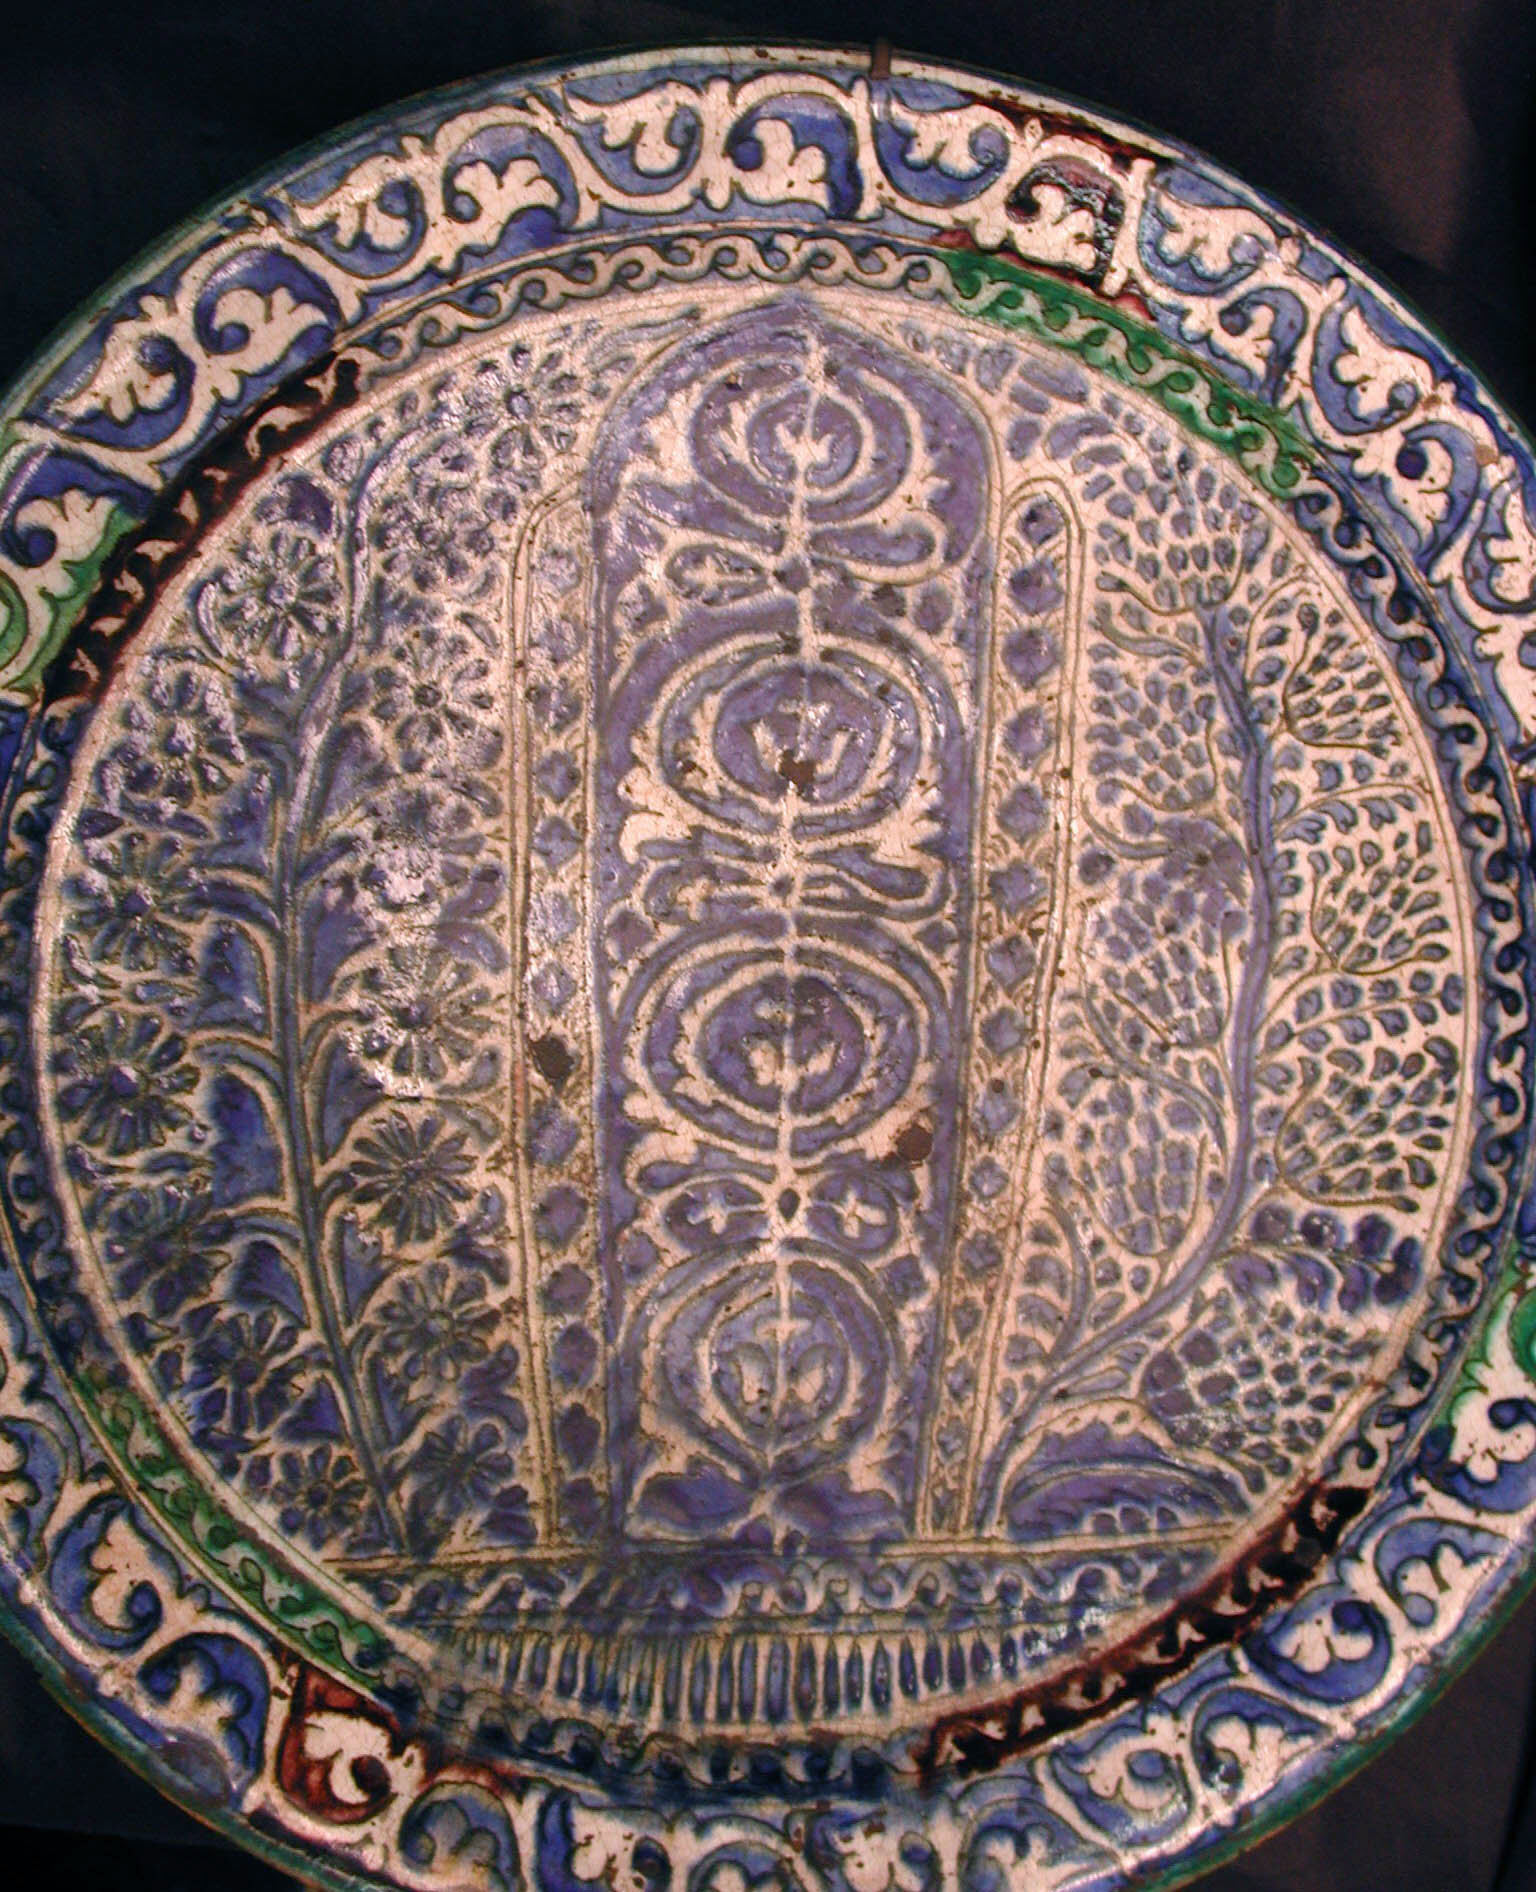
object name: dish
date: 1701-1900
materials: stonepaste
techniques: painting, underglaze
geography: uzbekistan